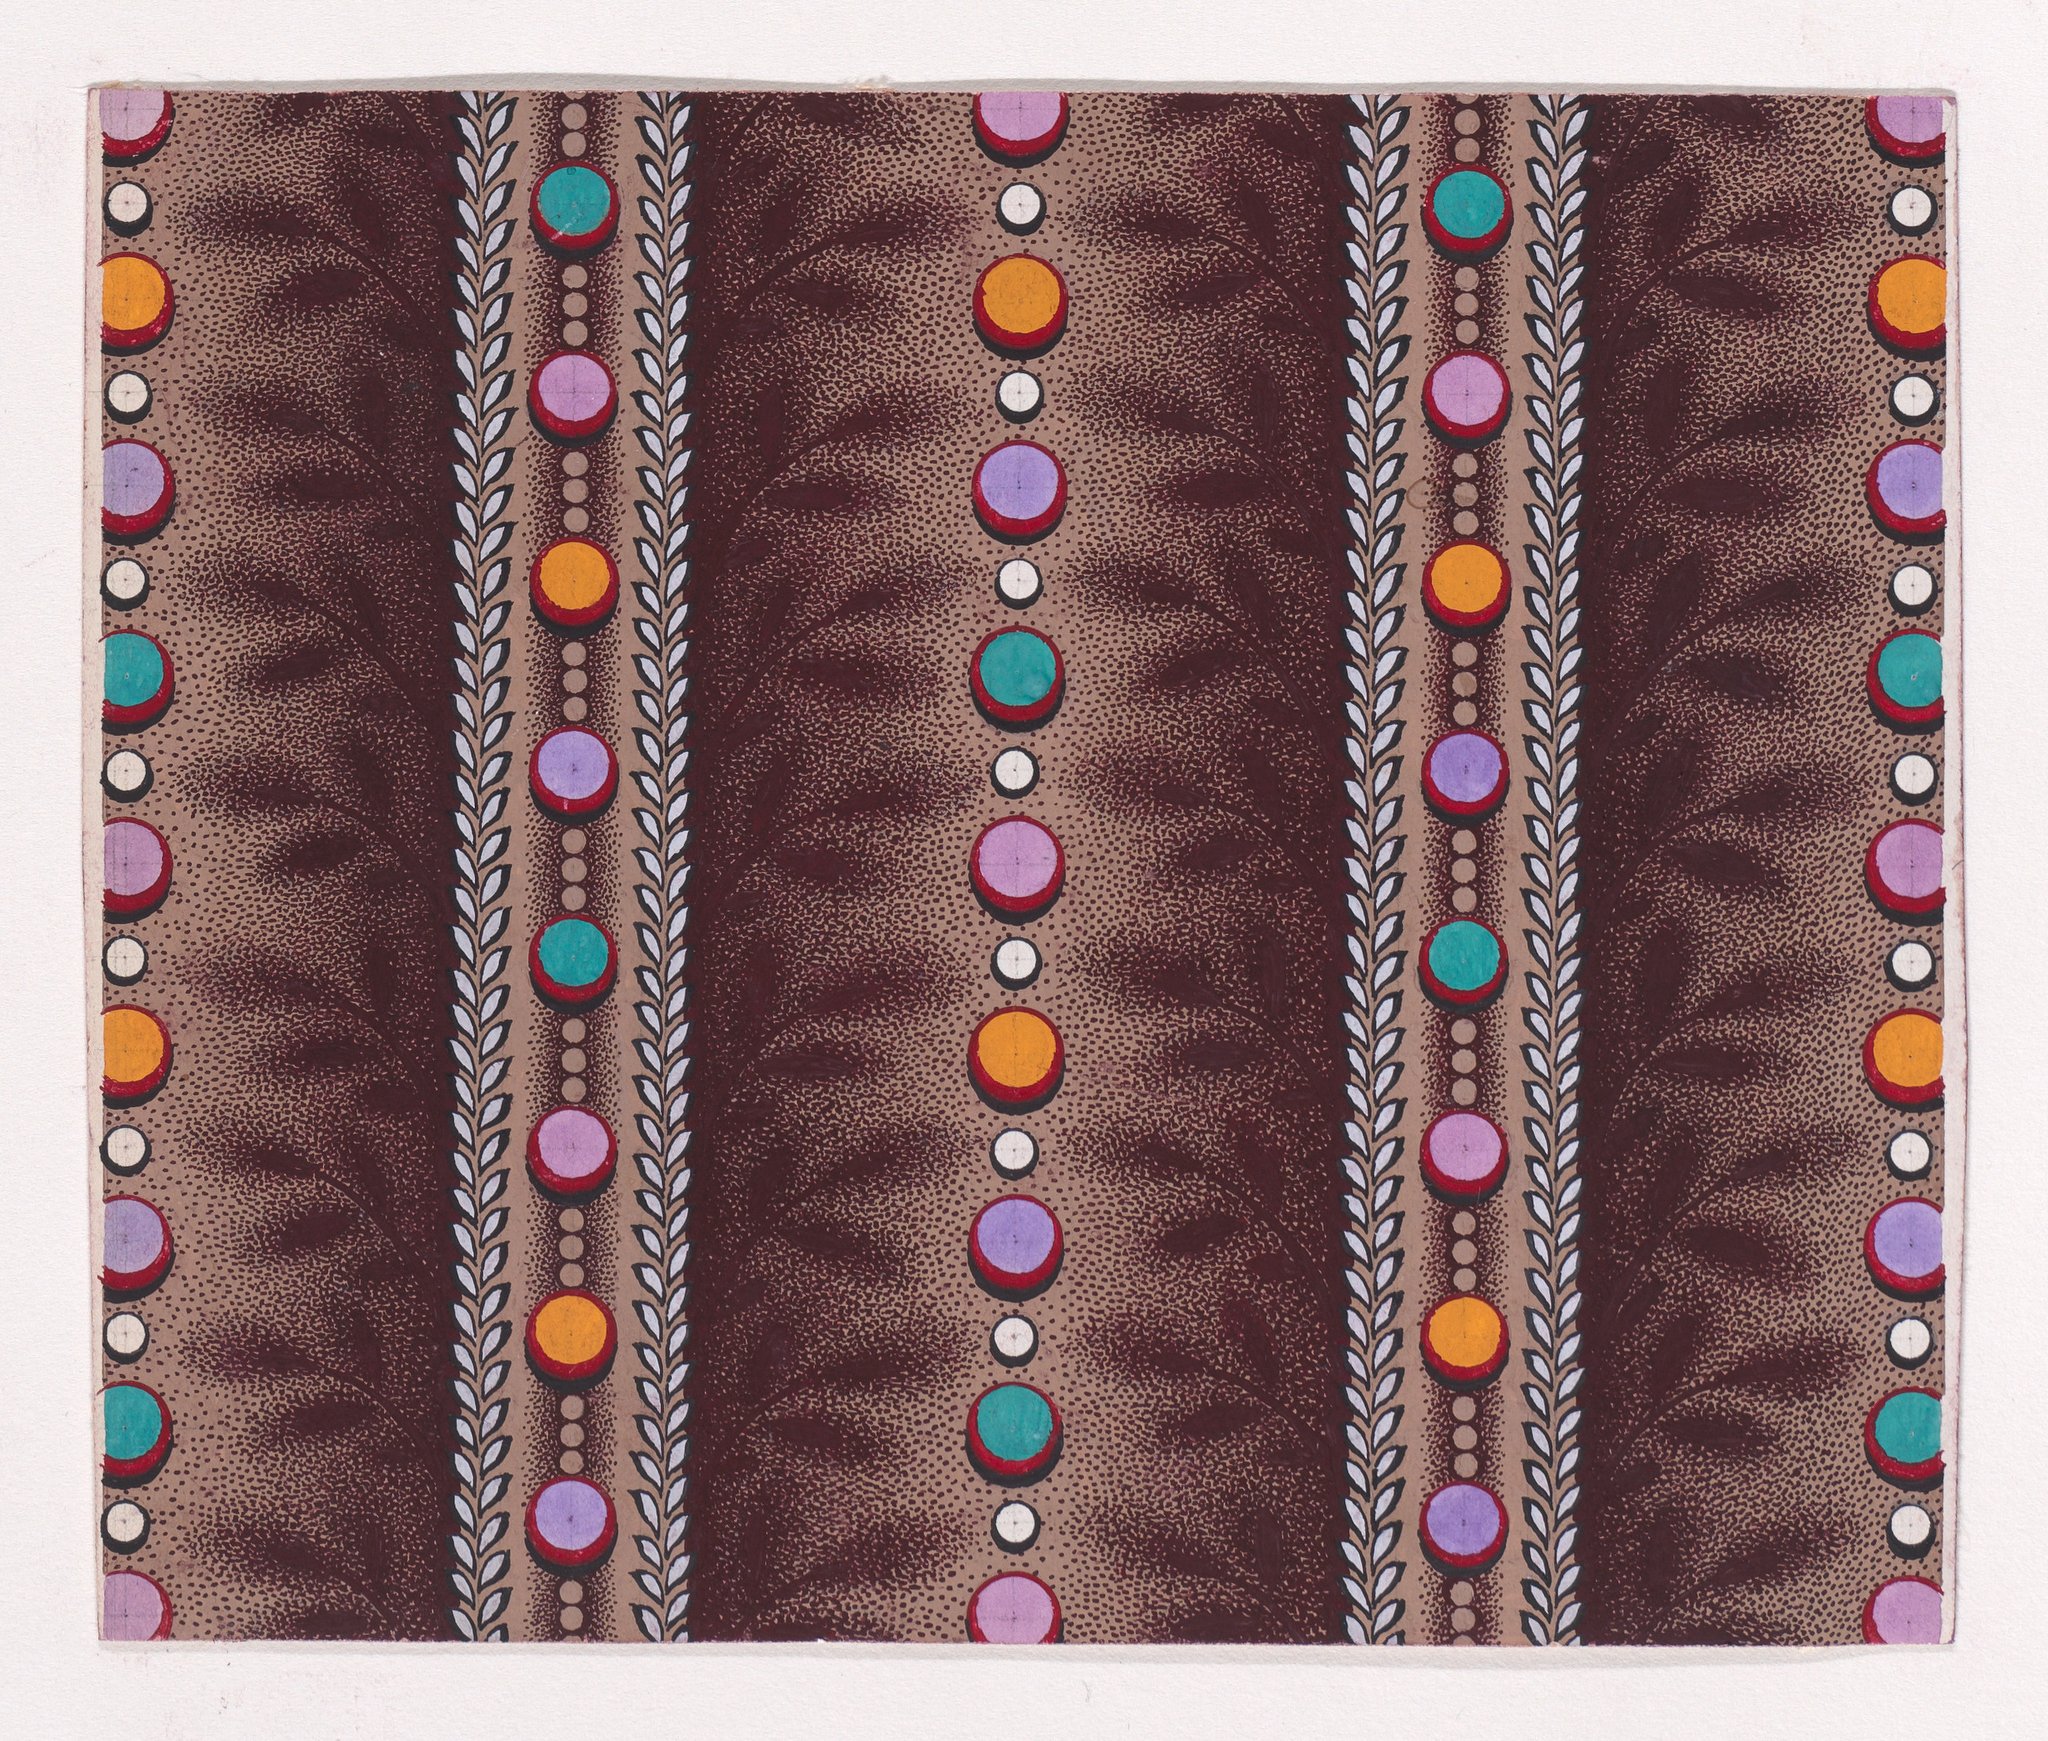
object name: drawing ornament architecture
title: Textile Design with Alternating Vertical Strips of Pearls and Stylized Leaves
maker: anonymous, alsatian, 19th century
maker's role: artist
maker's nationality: alsatian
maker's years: 1800-1900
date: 1840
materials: gouache